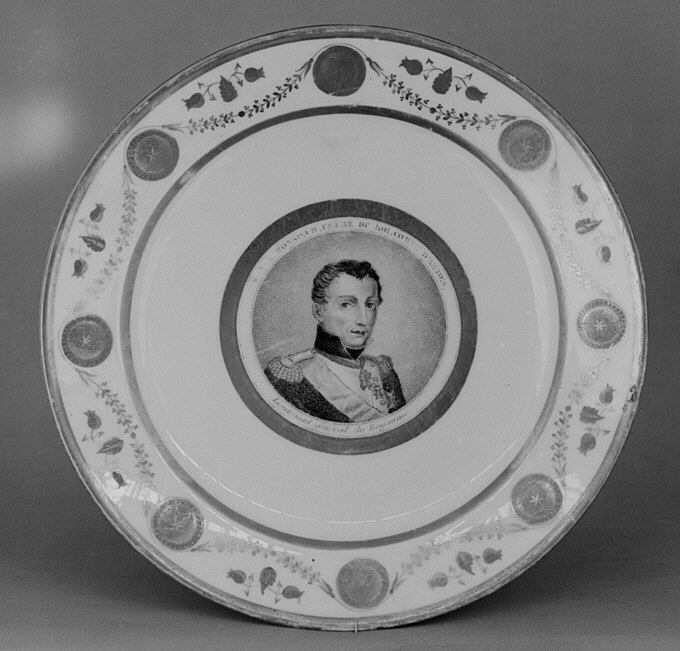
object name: plate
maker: rue de popincourt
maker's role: factory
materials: hard paste porcelain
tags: men,portraits